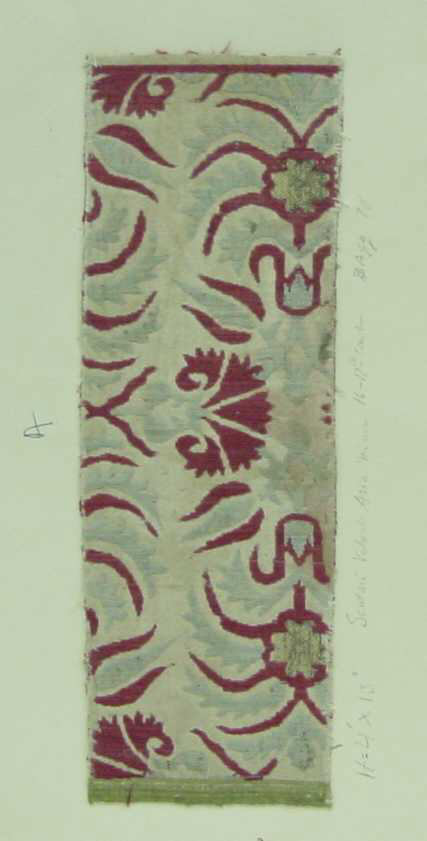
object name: textile fragment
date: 1501-1700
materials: metal thread, silk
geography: turkey